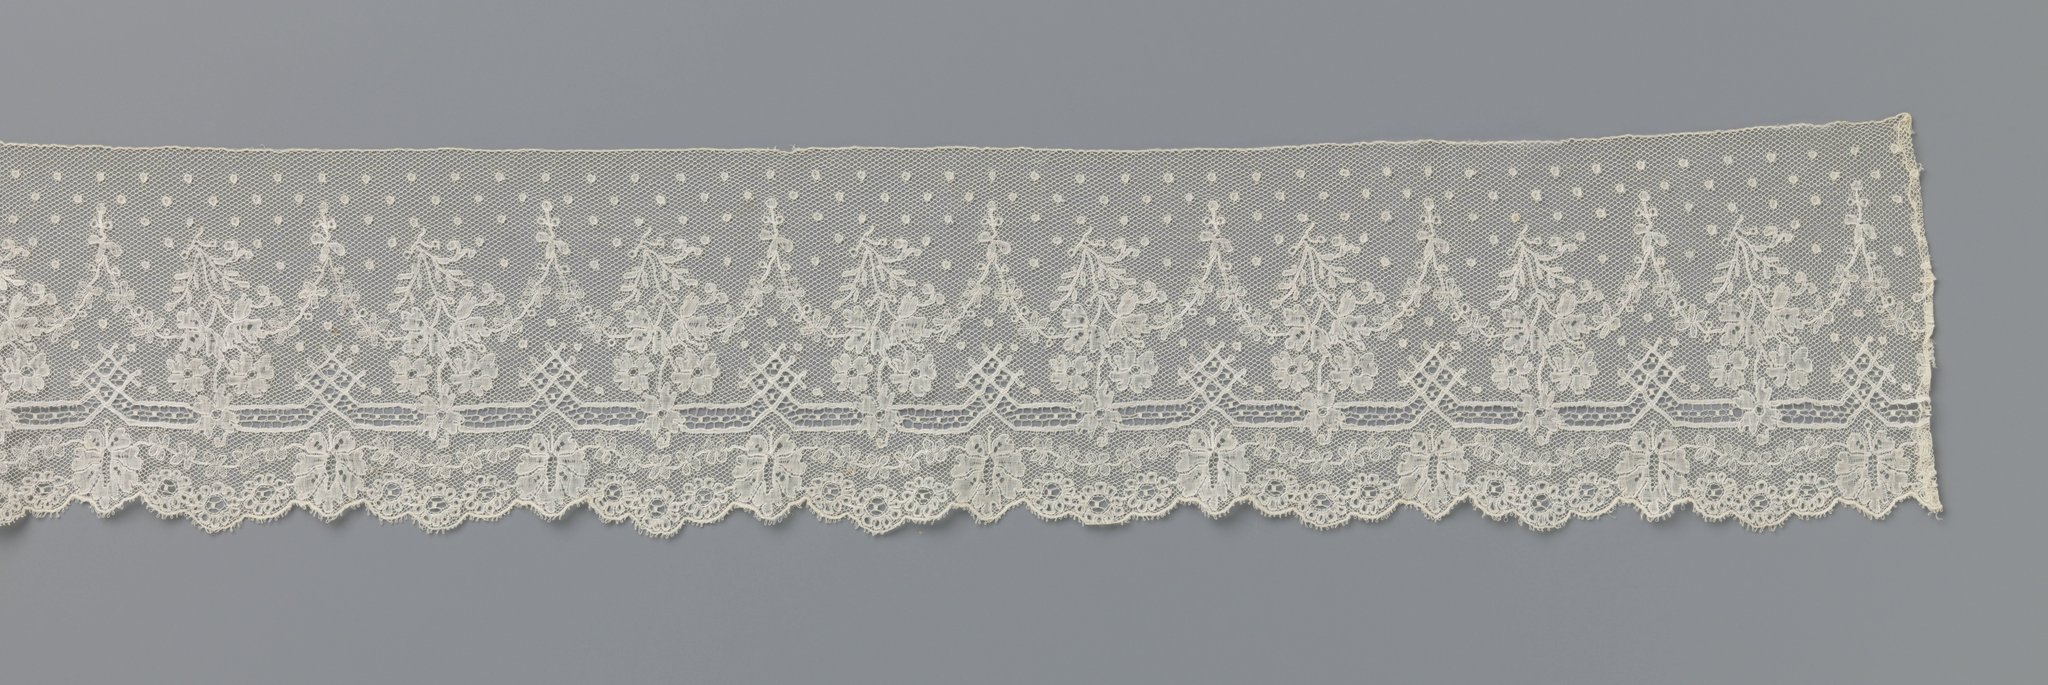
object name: strip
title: Strook kloskant met open profiellijst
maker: Anonymous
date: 1870-1890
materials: linen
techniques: lace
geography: turnhout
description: Strook naturelkleurig kloskant: Mechelse kant. Op een met moesjes bezaaide traliegrond (een Mechelse grond of ijsgrond) staat een symmetrisch patroon van een hangende bloemtak, die zowel een in de lucht hangende slinger als een open profiellijst oversnijdt; de lijst volgt de slinger, doch is hoekig getekend. De schulpjes zijn beurtelings van een wingerdblad en drie madeliefjes.